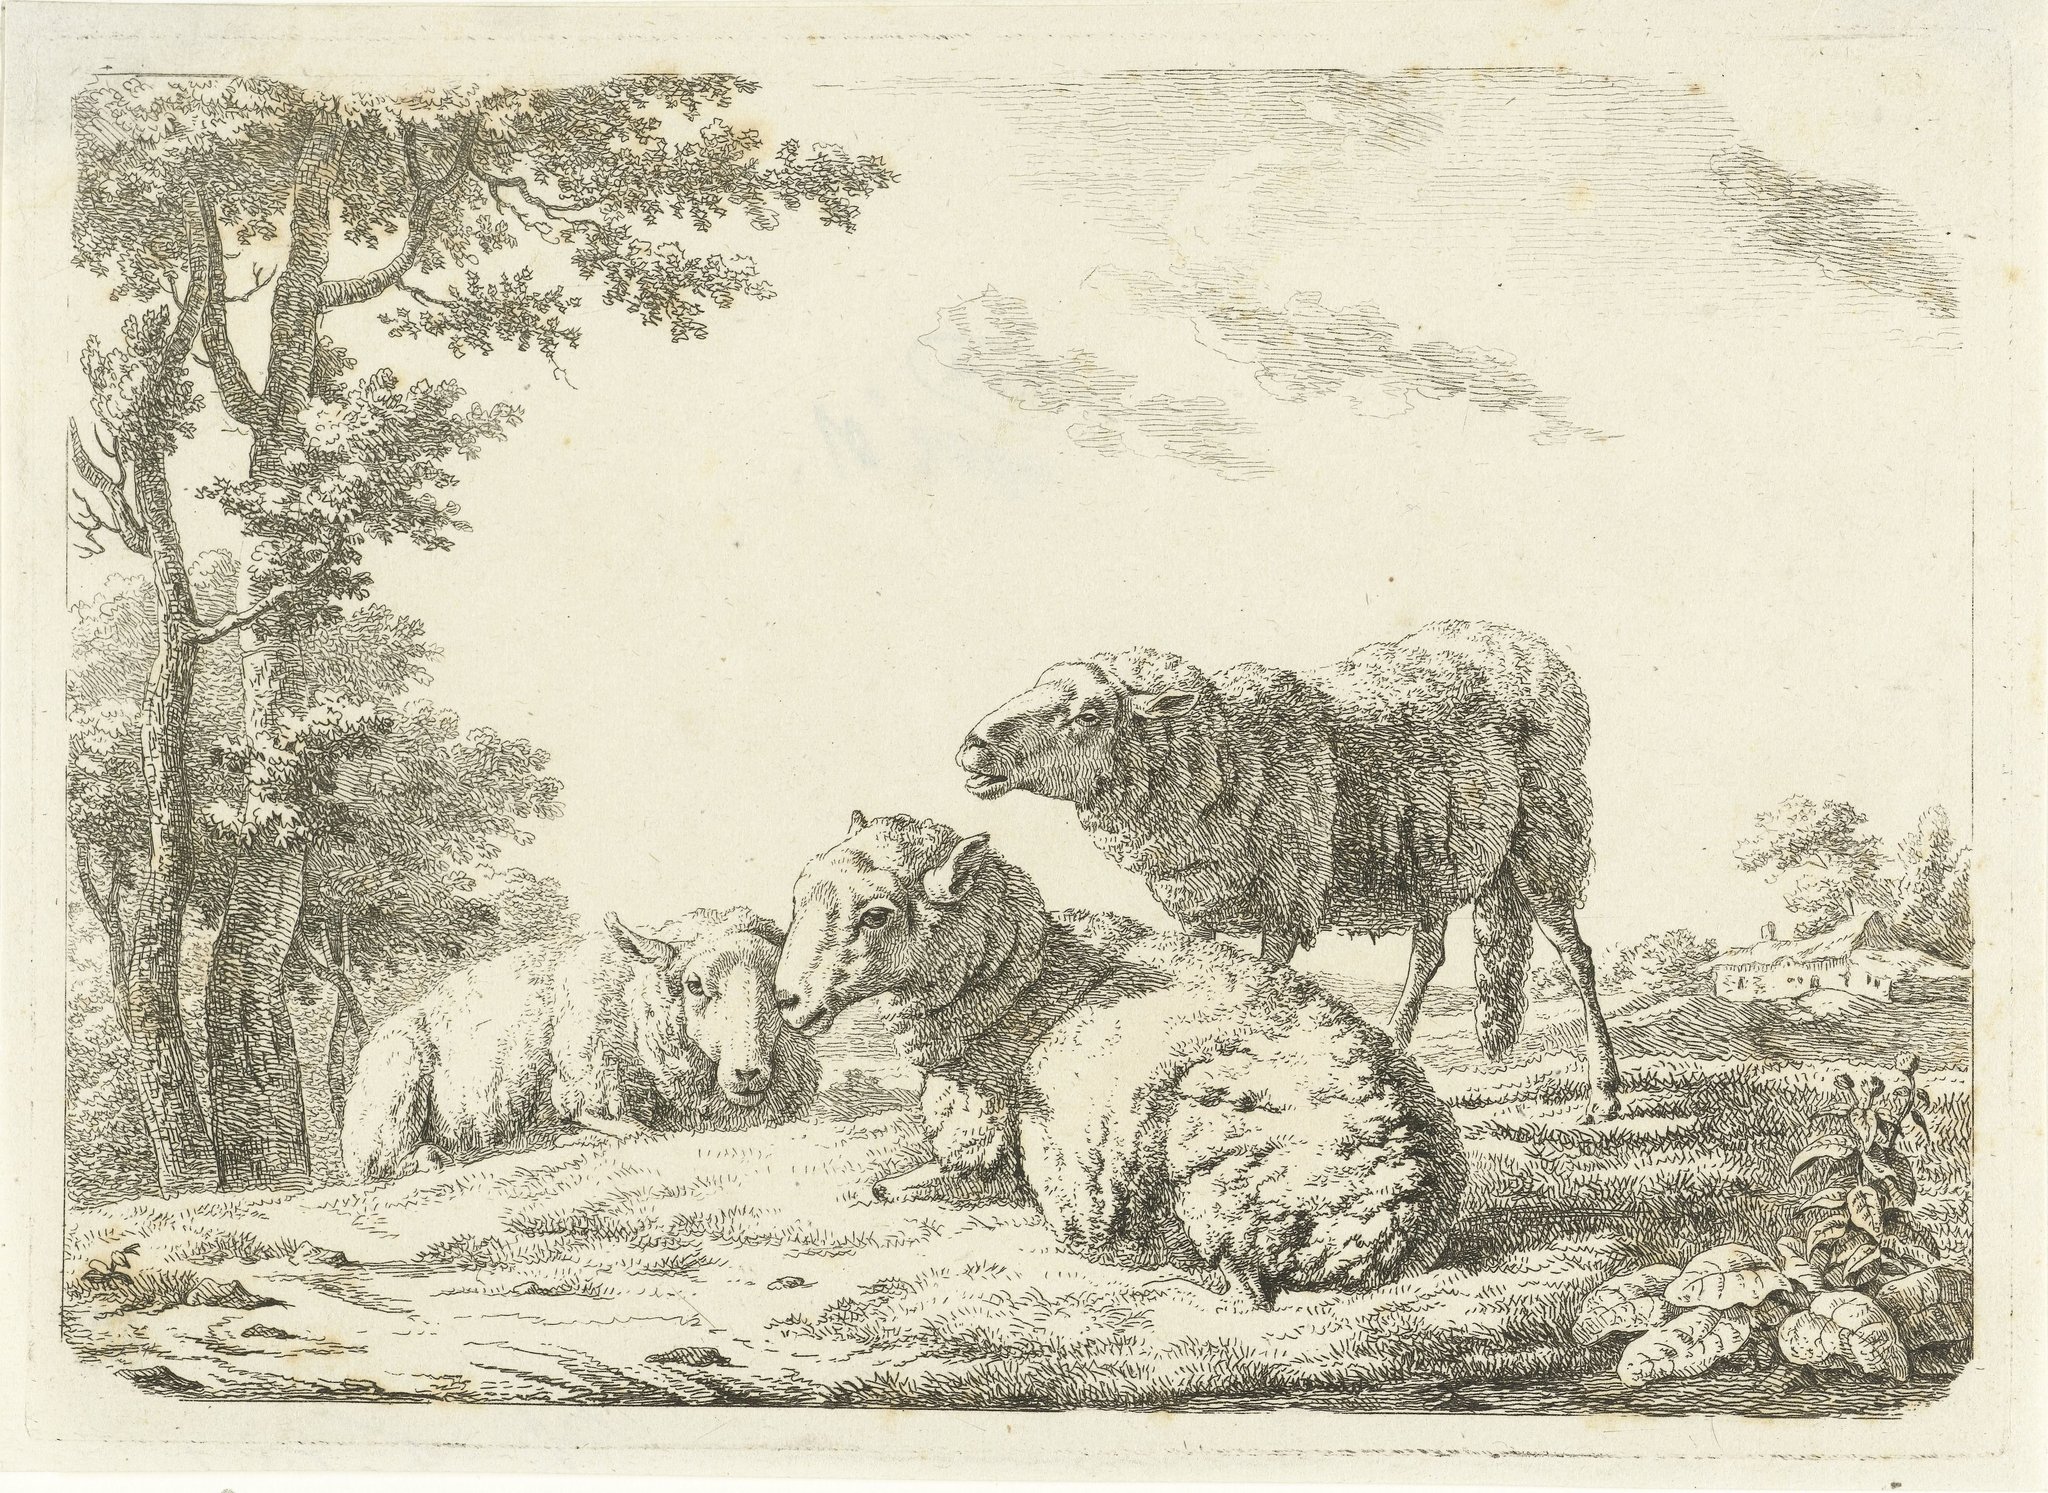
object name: print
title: Landschap met twee liggende en een staand schaap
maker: frédéric théodore faber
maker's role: print maker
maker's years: 1782-1844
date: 1817-1828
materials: paper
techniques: etching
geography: brussels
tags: sheep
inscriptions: collector's mark: Lugt 1485, collector's mark: Lugt 2228